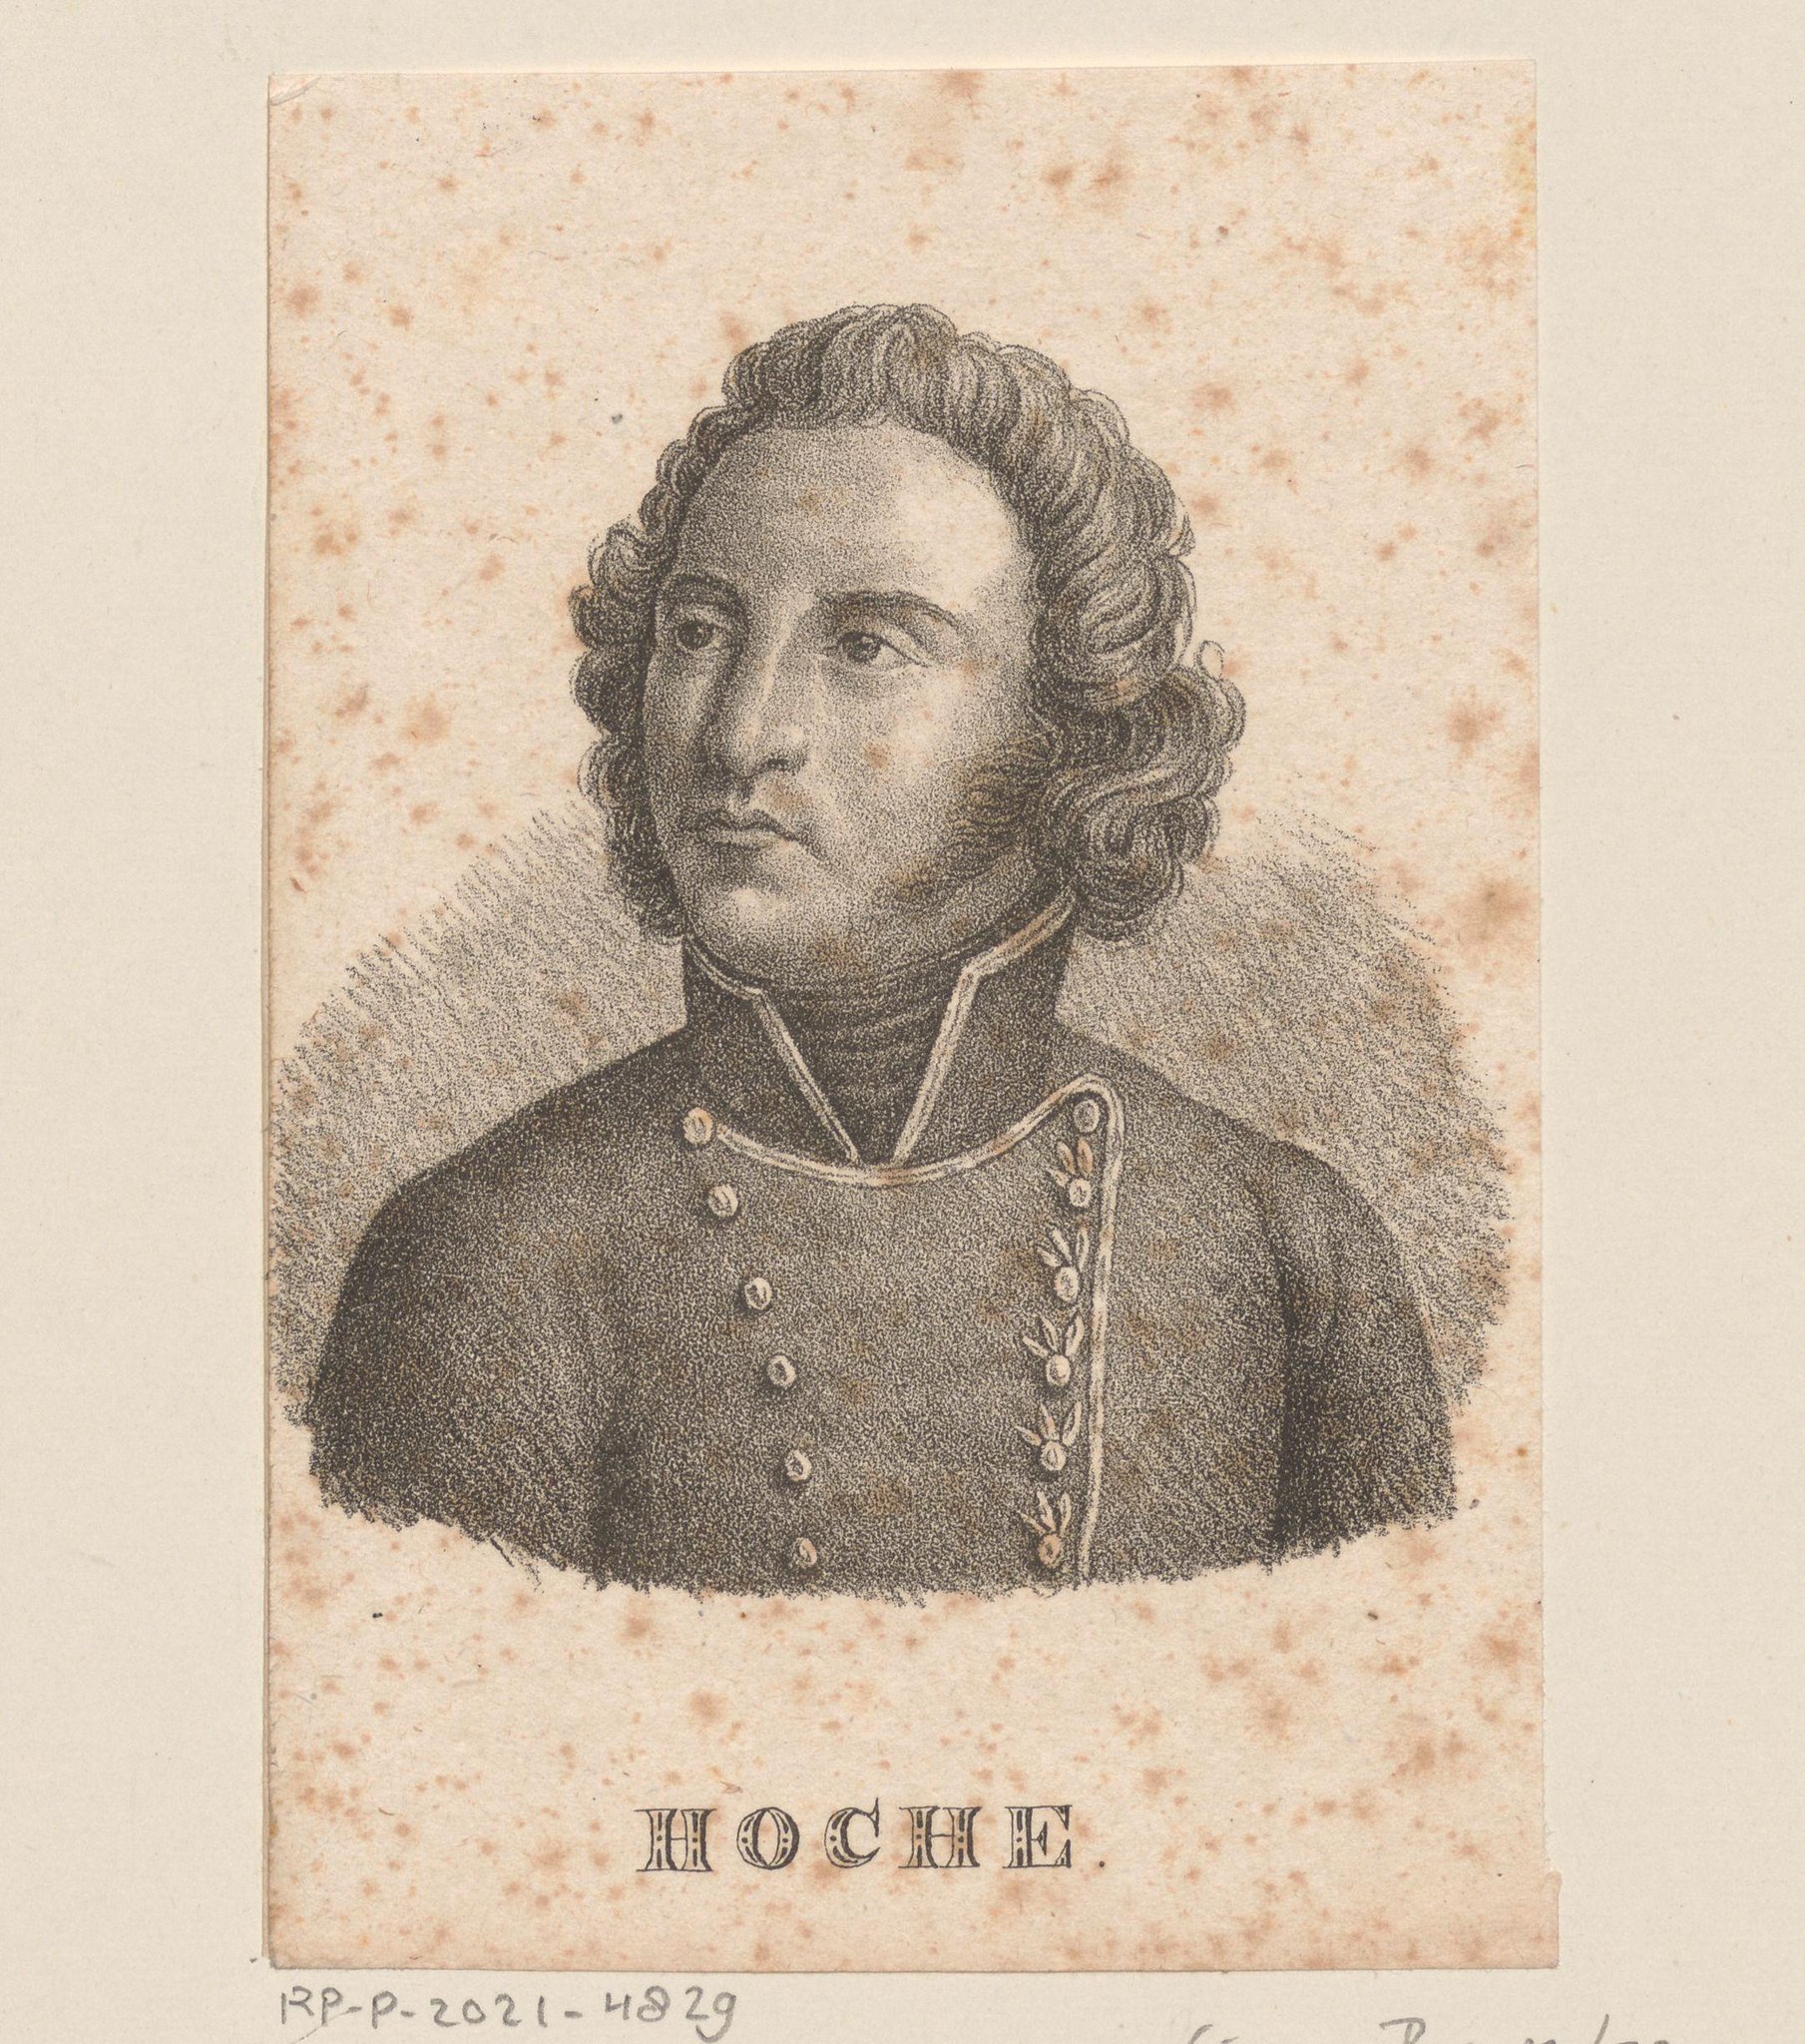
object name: print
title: Portret van Lazare Hoche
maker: Anonymous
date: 1825-1874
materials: paper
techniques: lithograph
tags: private soldier, historical persons